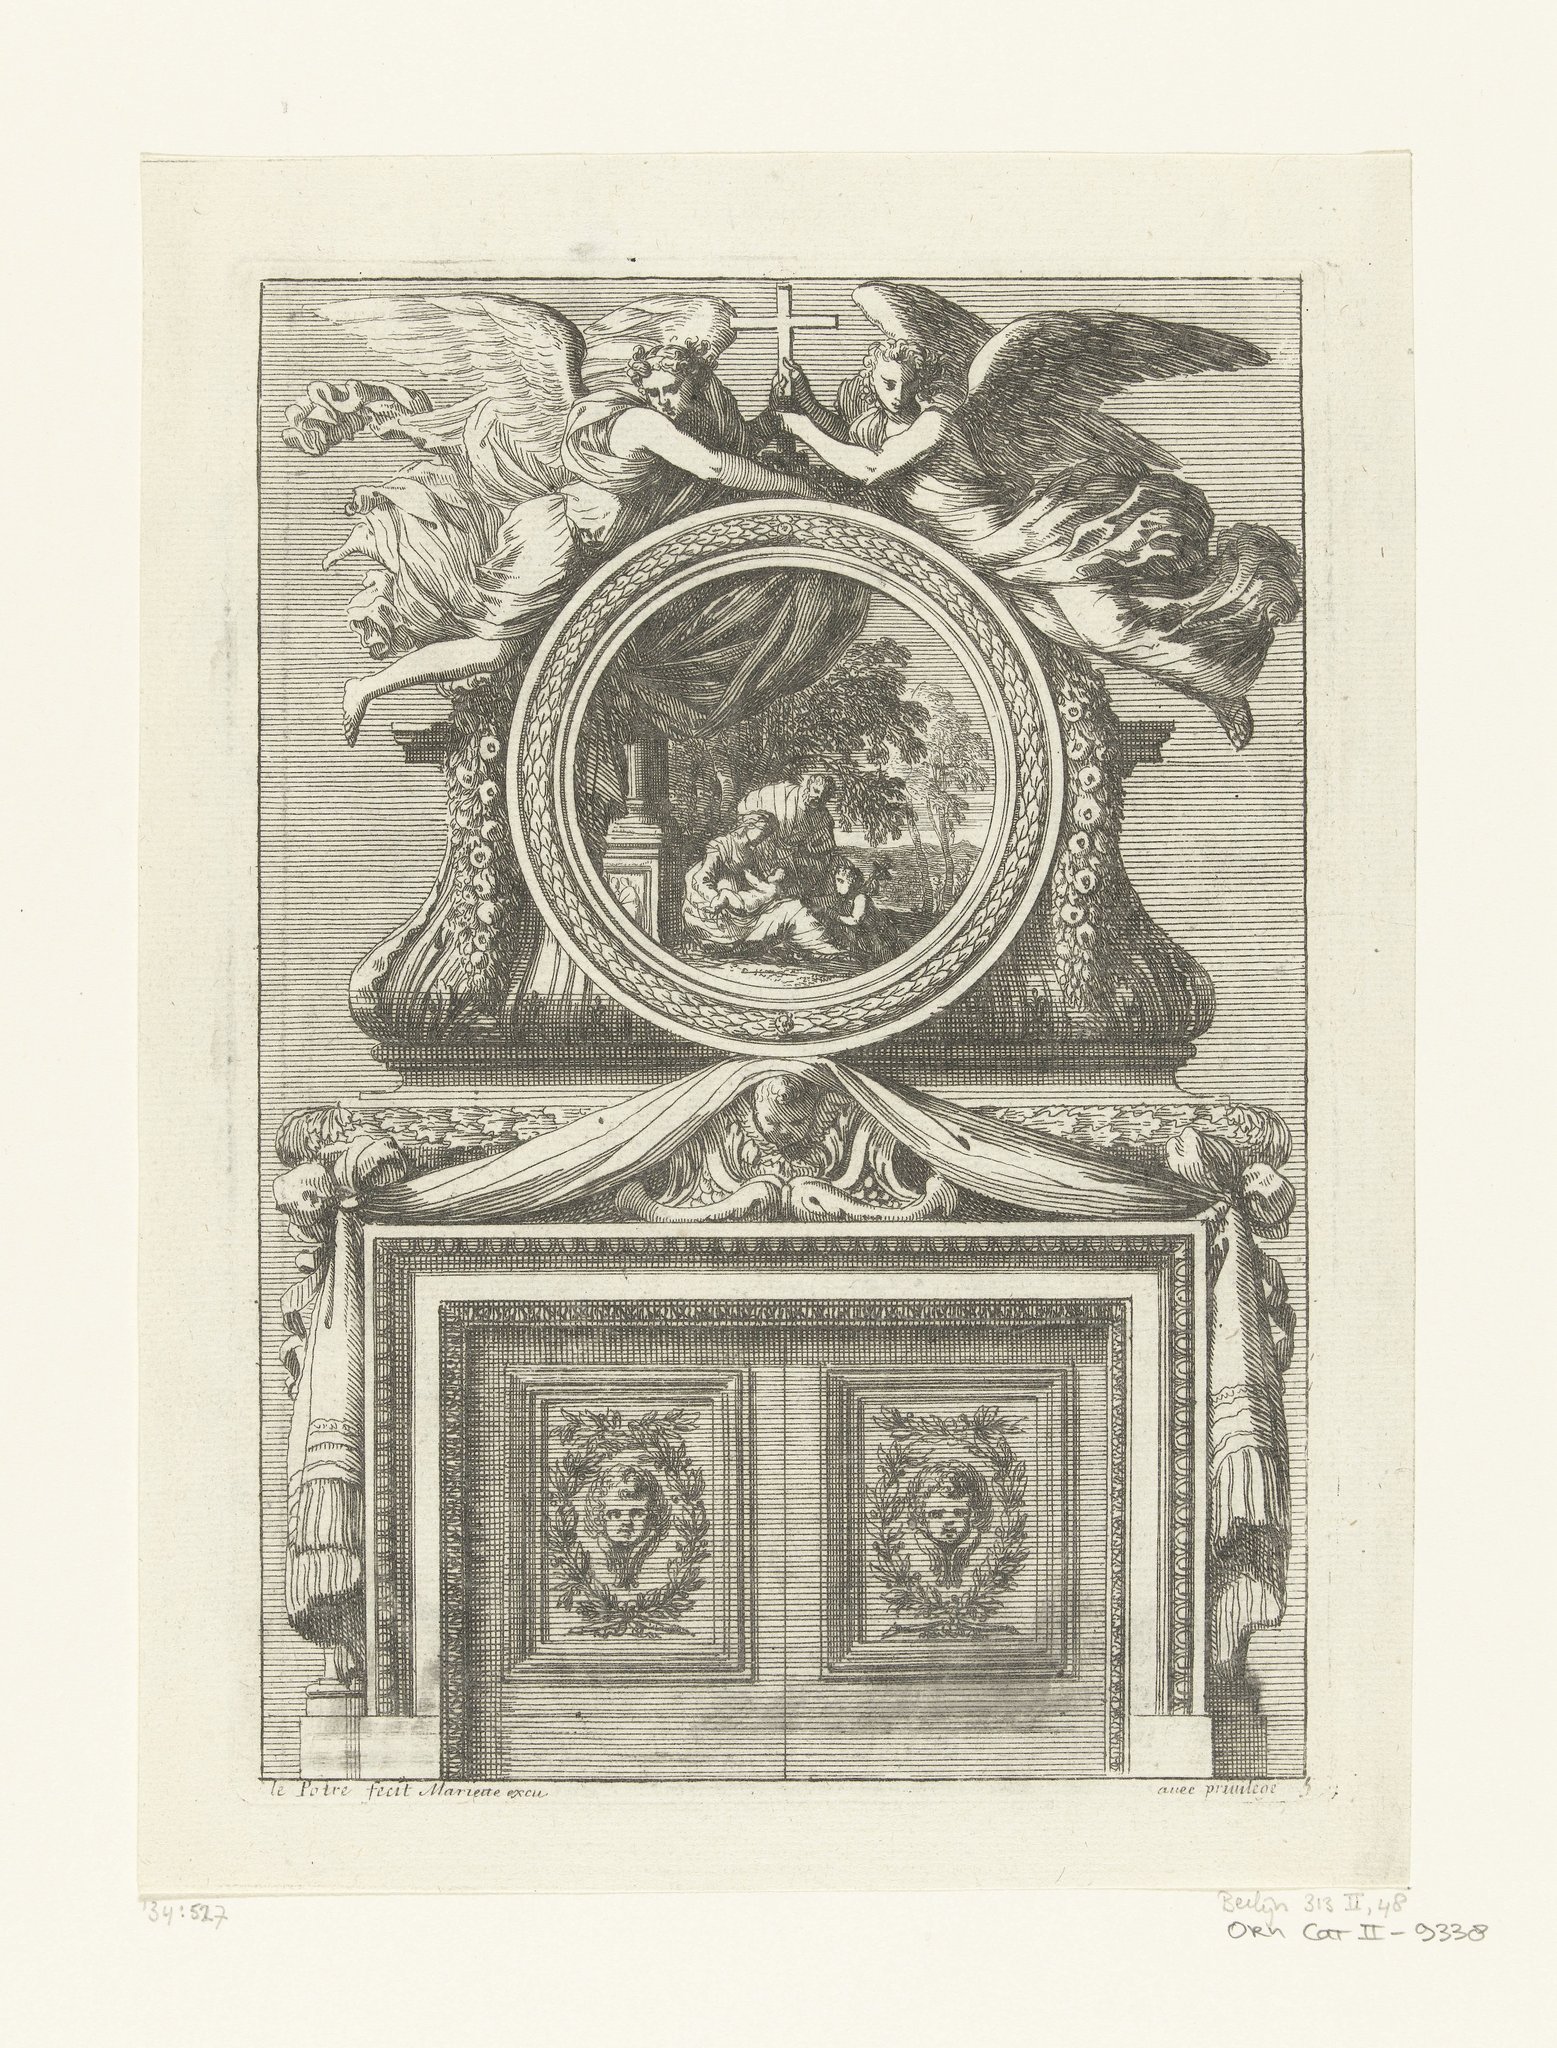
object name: print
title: Cheminées à la Moderne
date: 1661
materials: paper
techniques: etching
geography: france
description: Op het schilderij staat de Aanbidding van Christus. Uit derde editie.